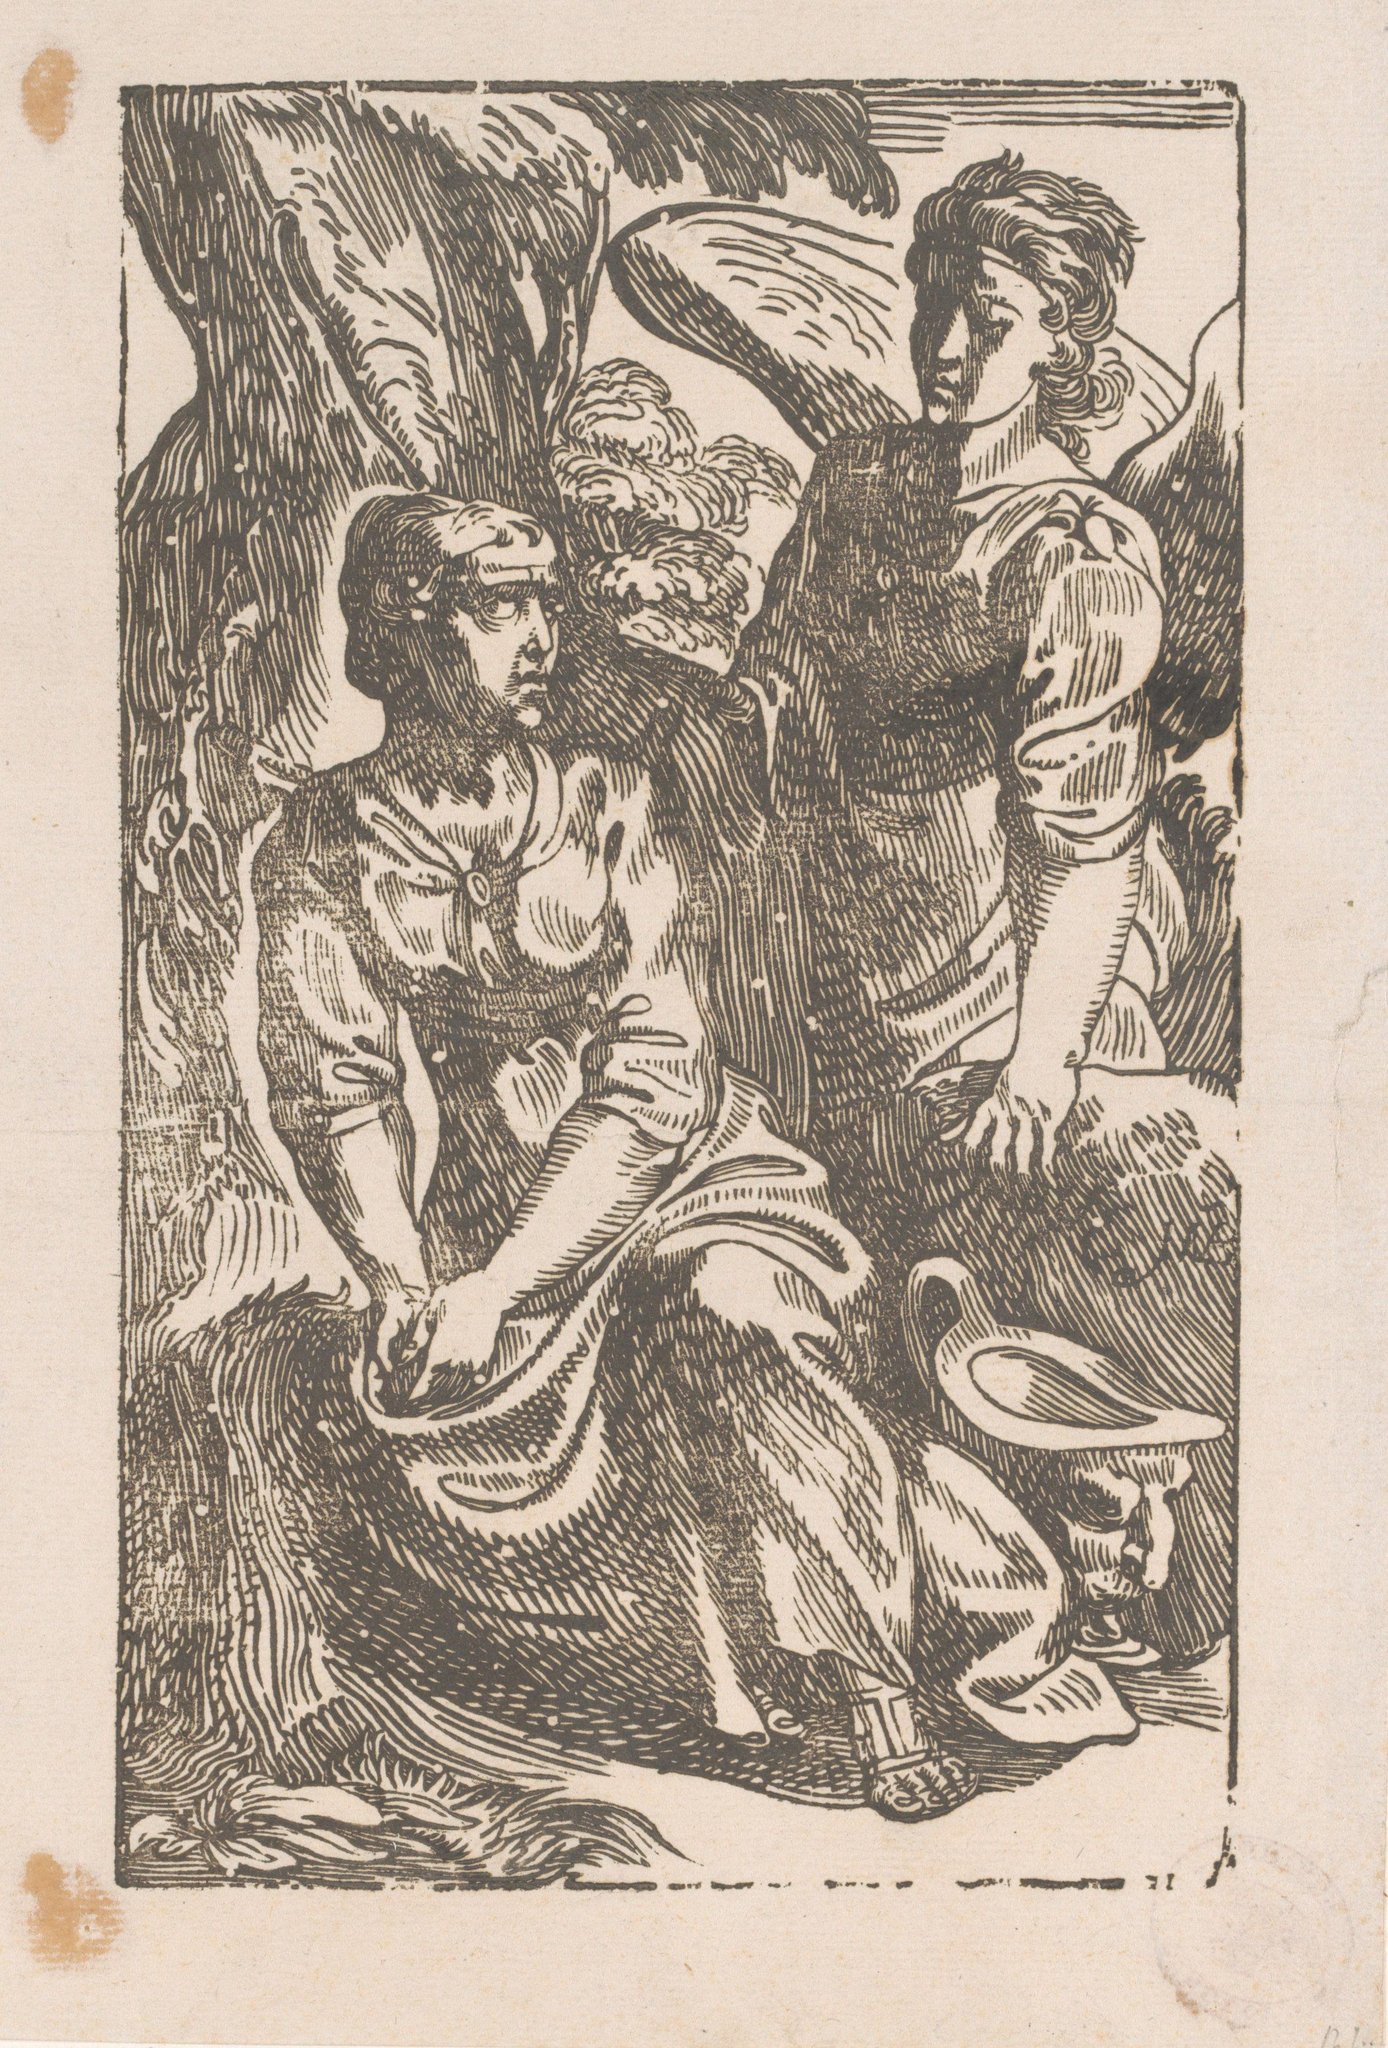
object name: print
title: Hagar en de engel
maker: moyses van wtenbrouck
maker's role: painter, print maker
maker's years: 1590-1647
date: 1615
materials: paper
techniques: woodcut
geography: the hague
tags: an angel meets hagar at the fountain on the way to shur and persuades her to return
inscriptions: collector's mark: Lugt 240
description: Hagar zit in de woestijn bij een bron, waar een engel van de Heer haar aanspreekt en haar opdraagt om terug te gaan.